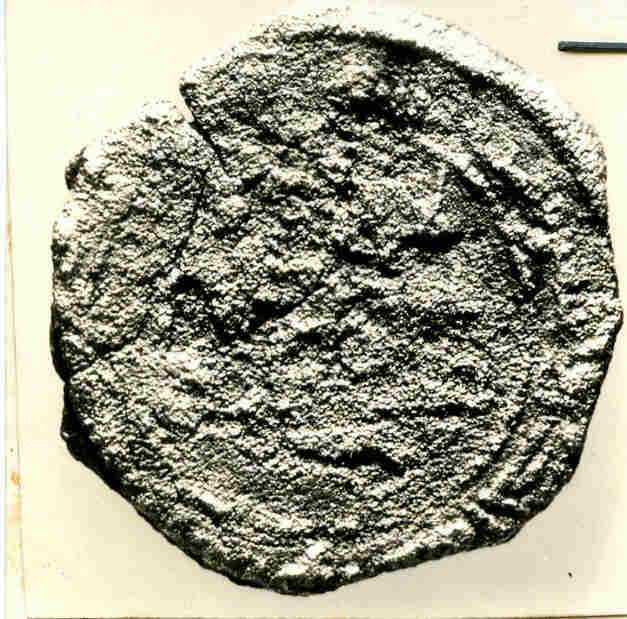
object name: coin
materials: copper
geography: iran